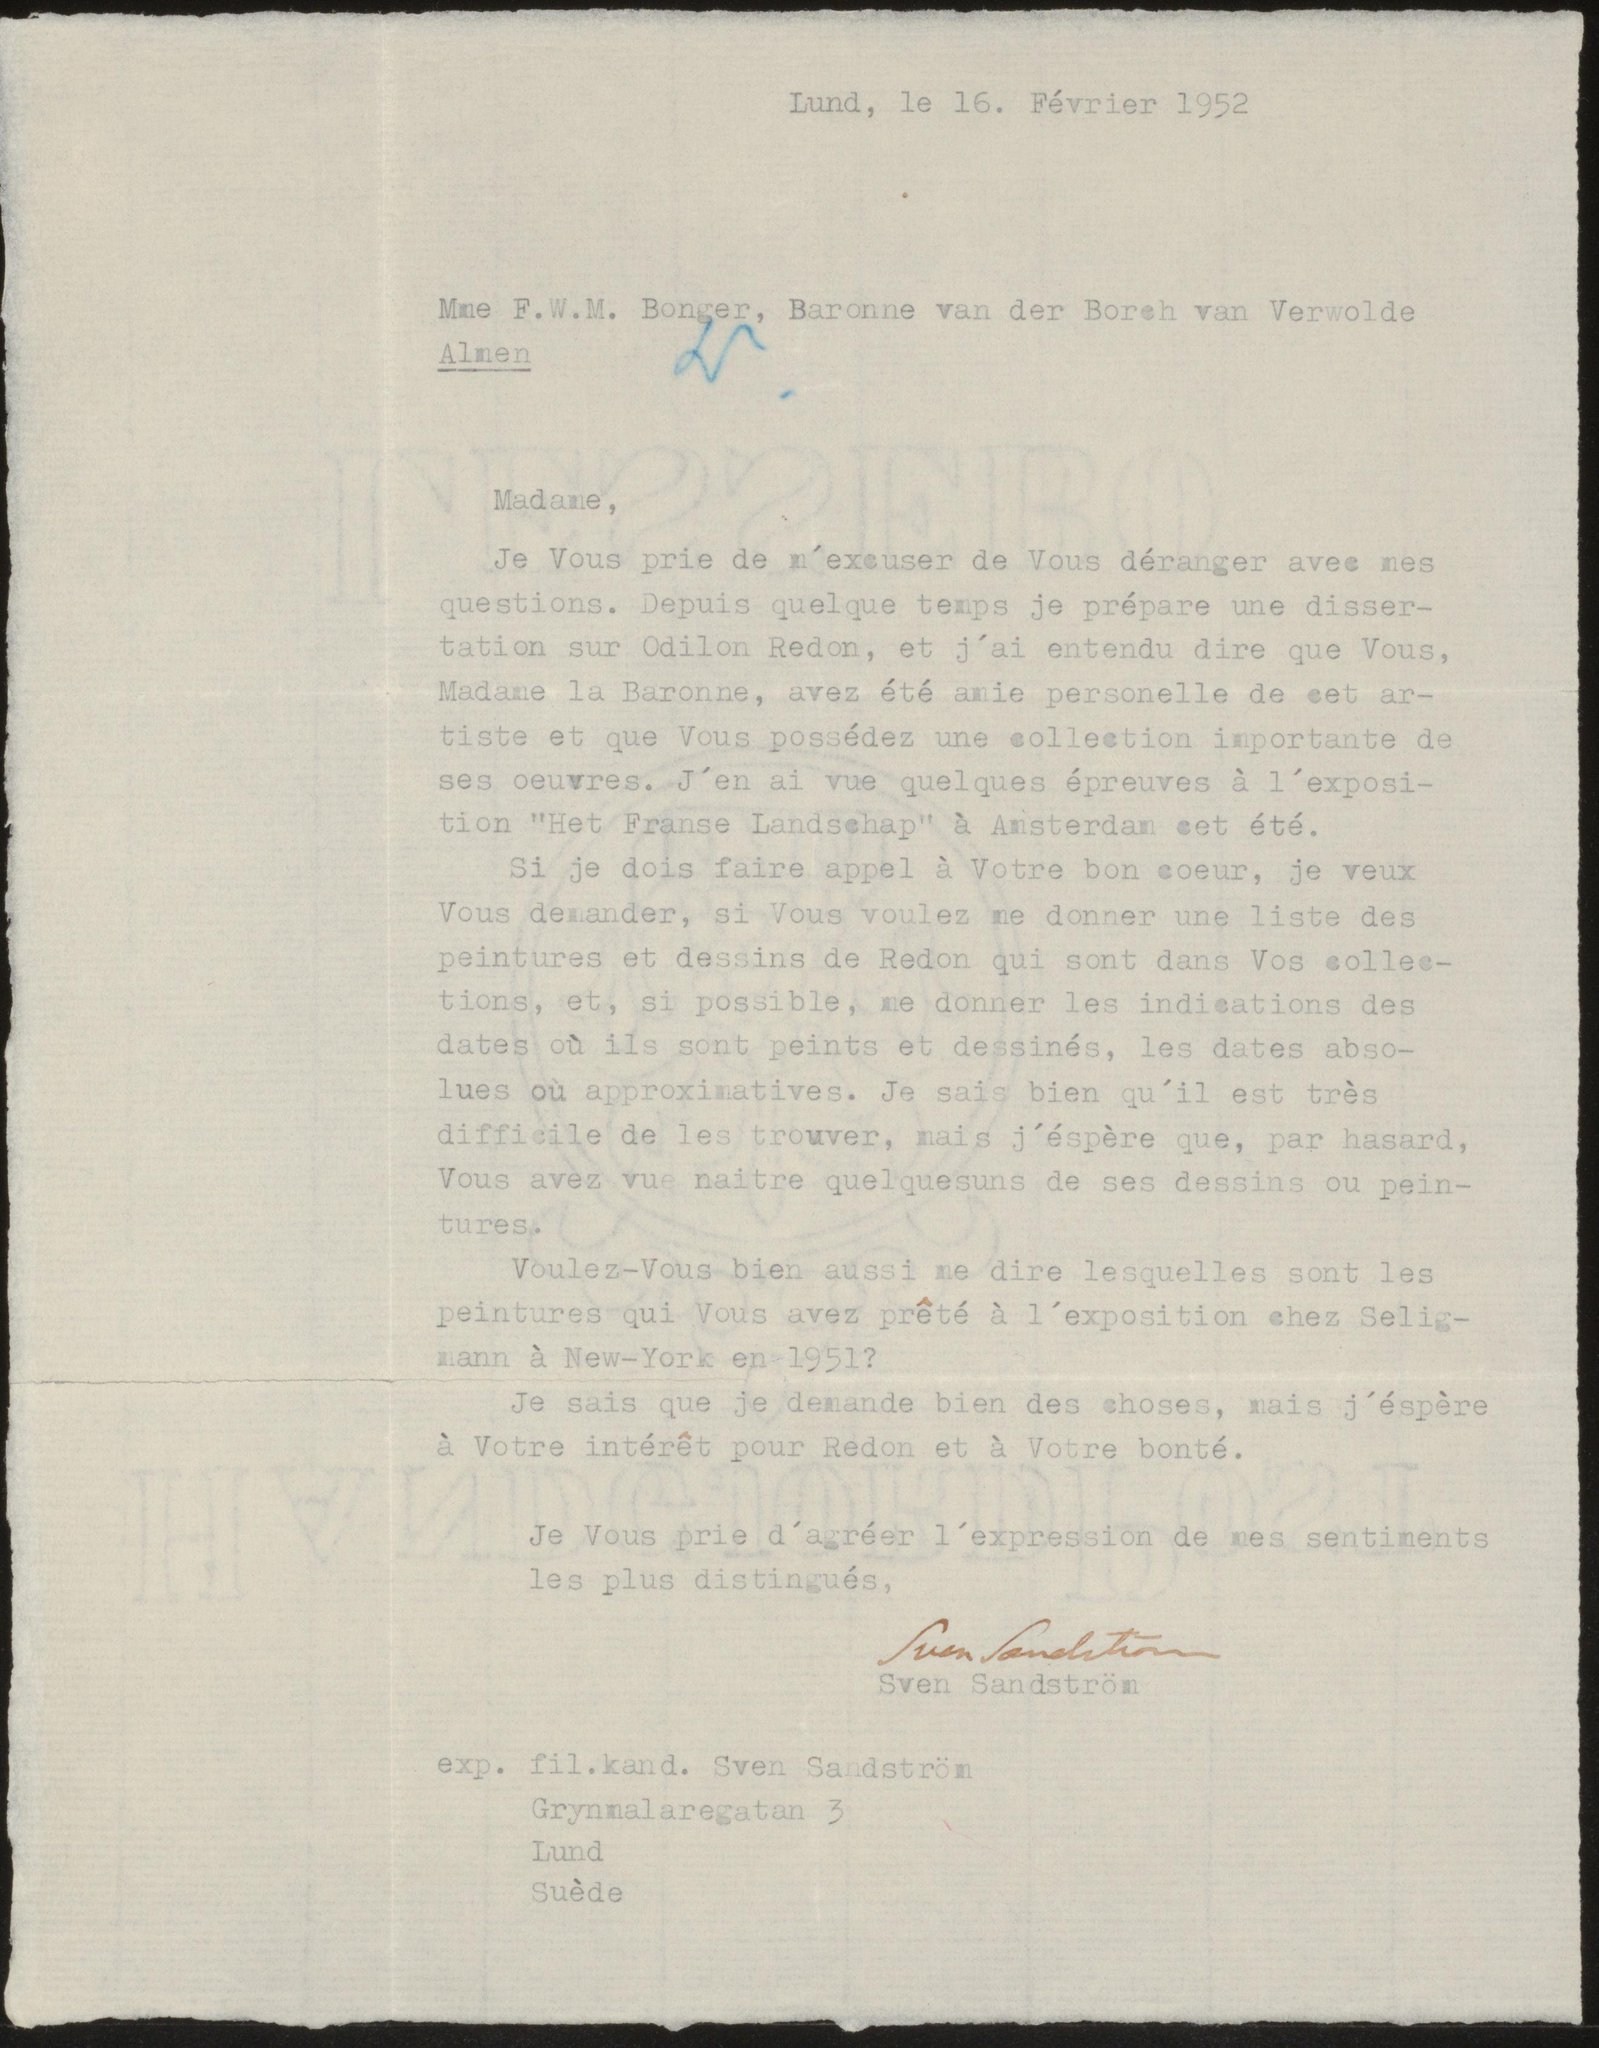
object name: letter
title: Brief aan Françoise W.M. Bonger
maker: sven sandström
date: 1952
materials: ink, paper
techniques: pen, typewriting, writing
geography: lund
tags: paris, painter, print maker, draughtsman, odilon redon, françoise w.m. bonger, drawing, painting (including book-illumination, miniature-painting), art collecting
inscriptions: watermark